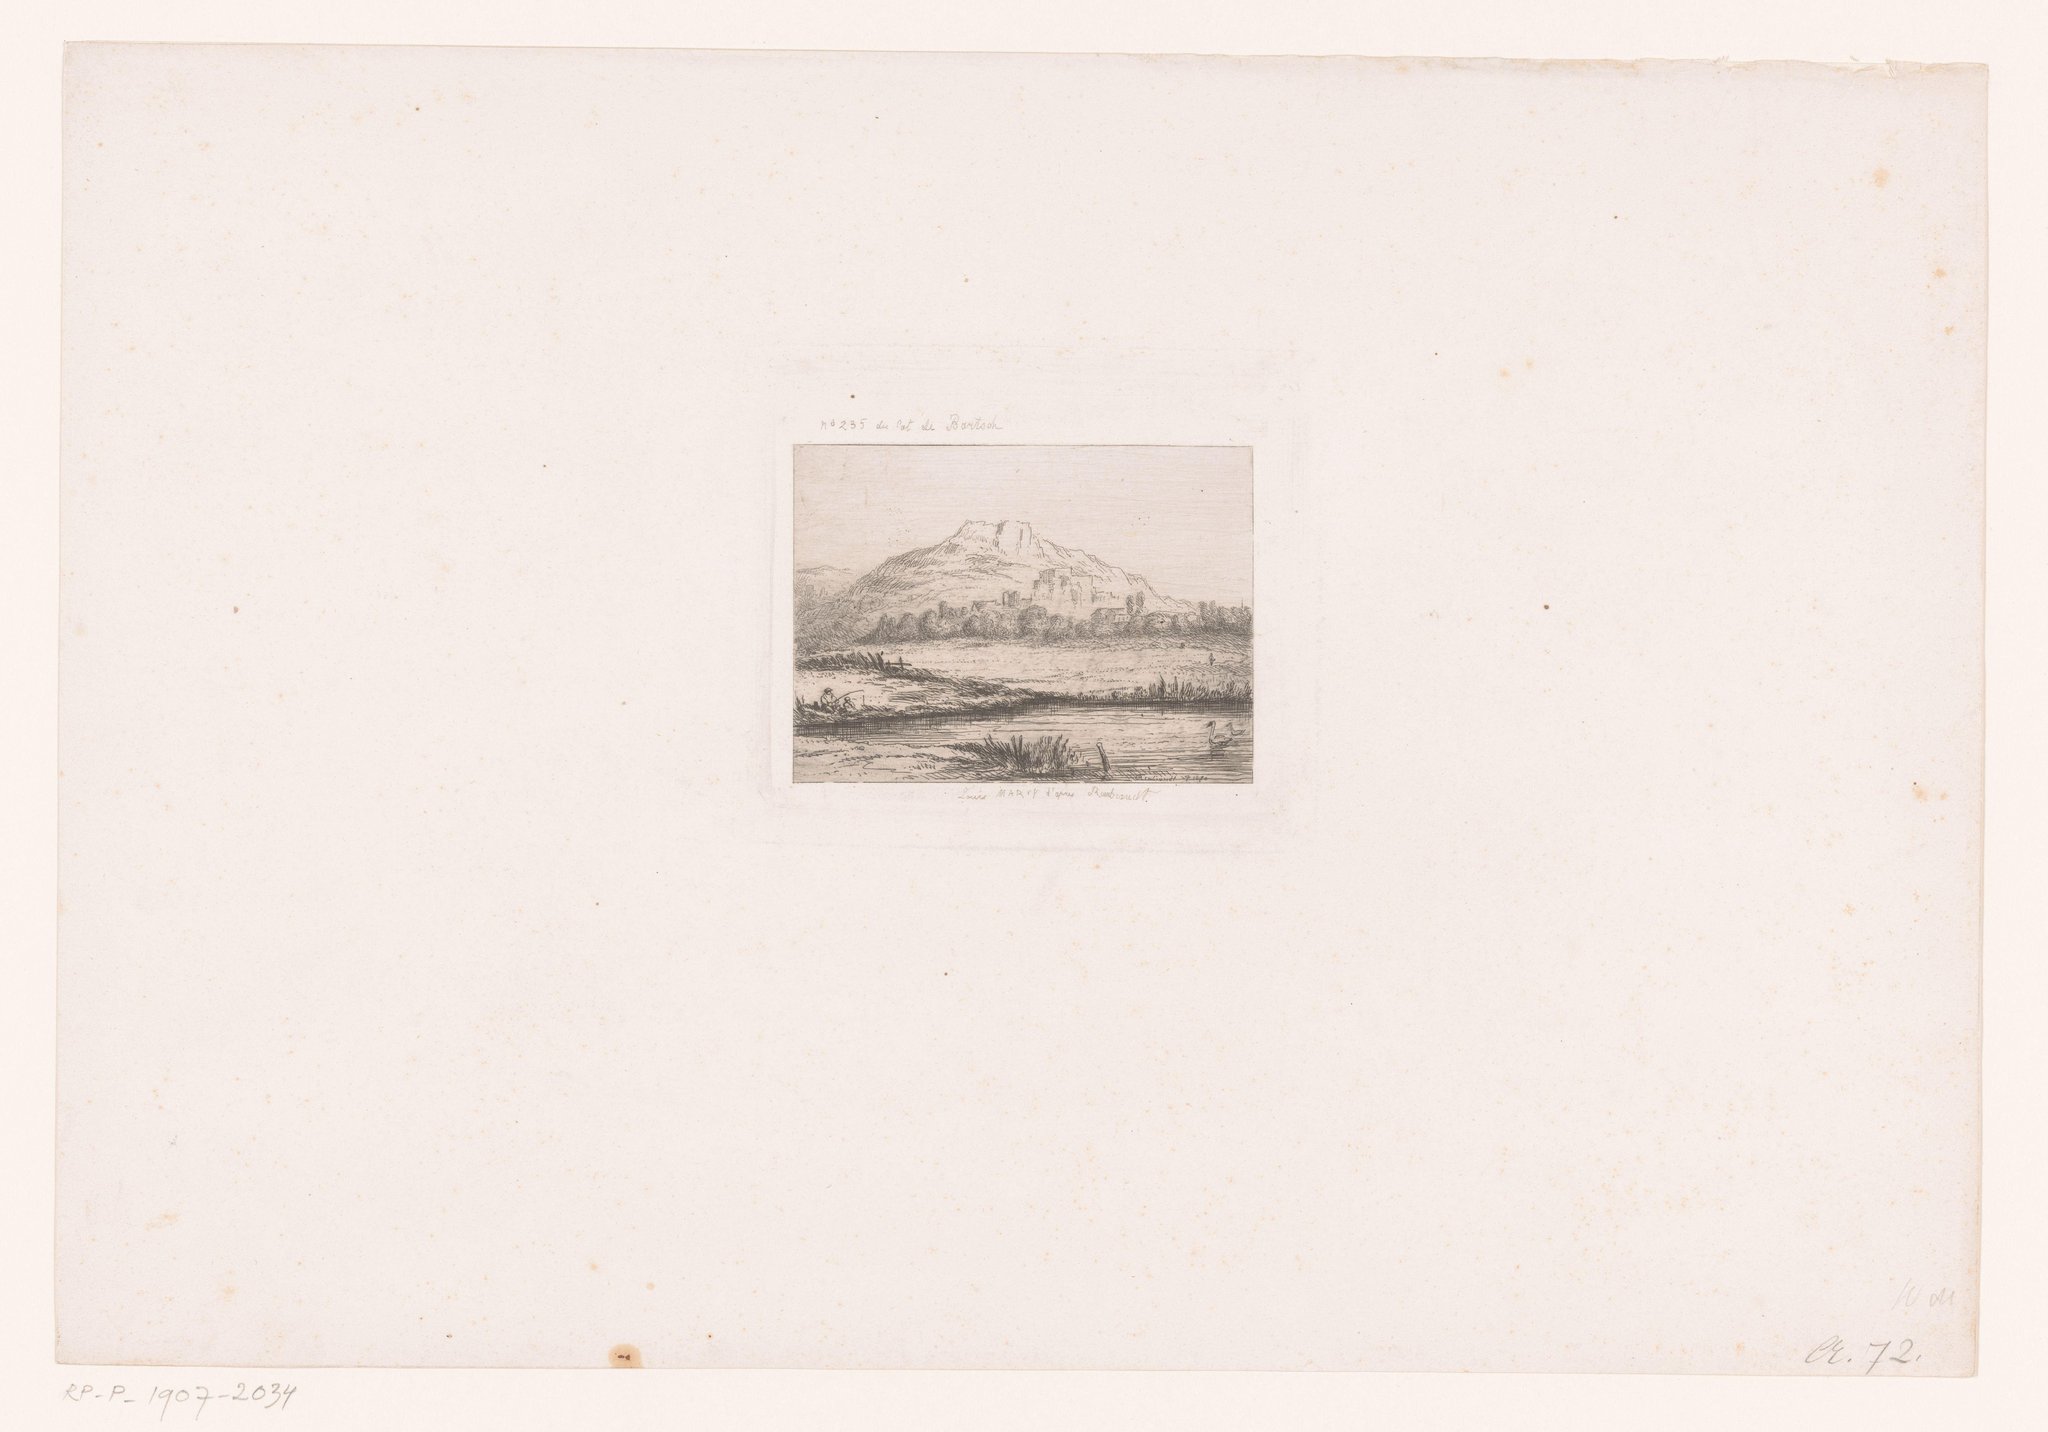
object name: print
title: Water met visser en twee zwanen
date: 1825-1850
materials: paper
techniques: etching, intaglio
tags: water-birds: swan, angling, mountains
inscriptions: collector's mark: Lugt 2228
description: Spiegelbeeldige kopie naar de gelijknamige prent van Rembrandt.